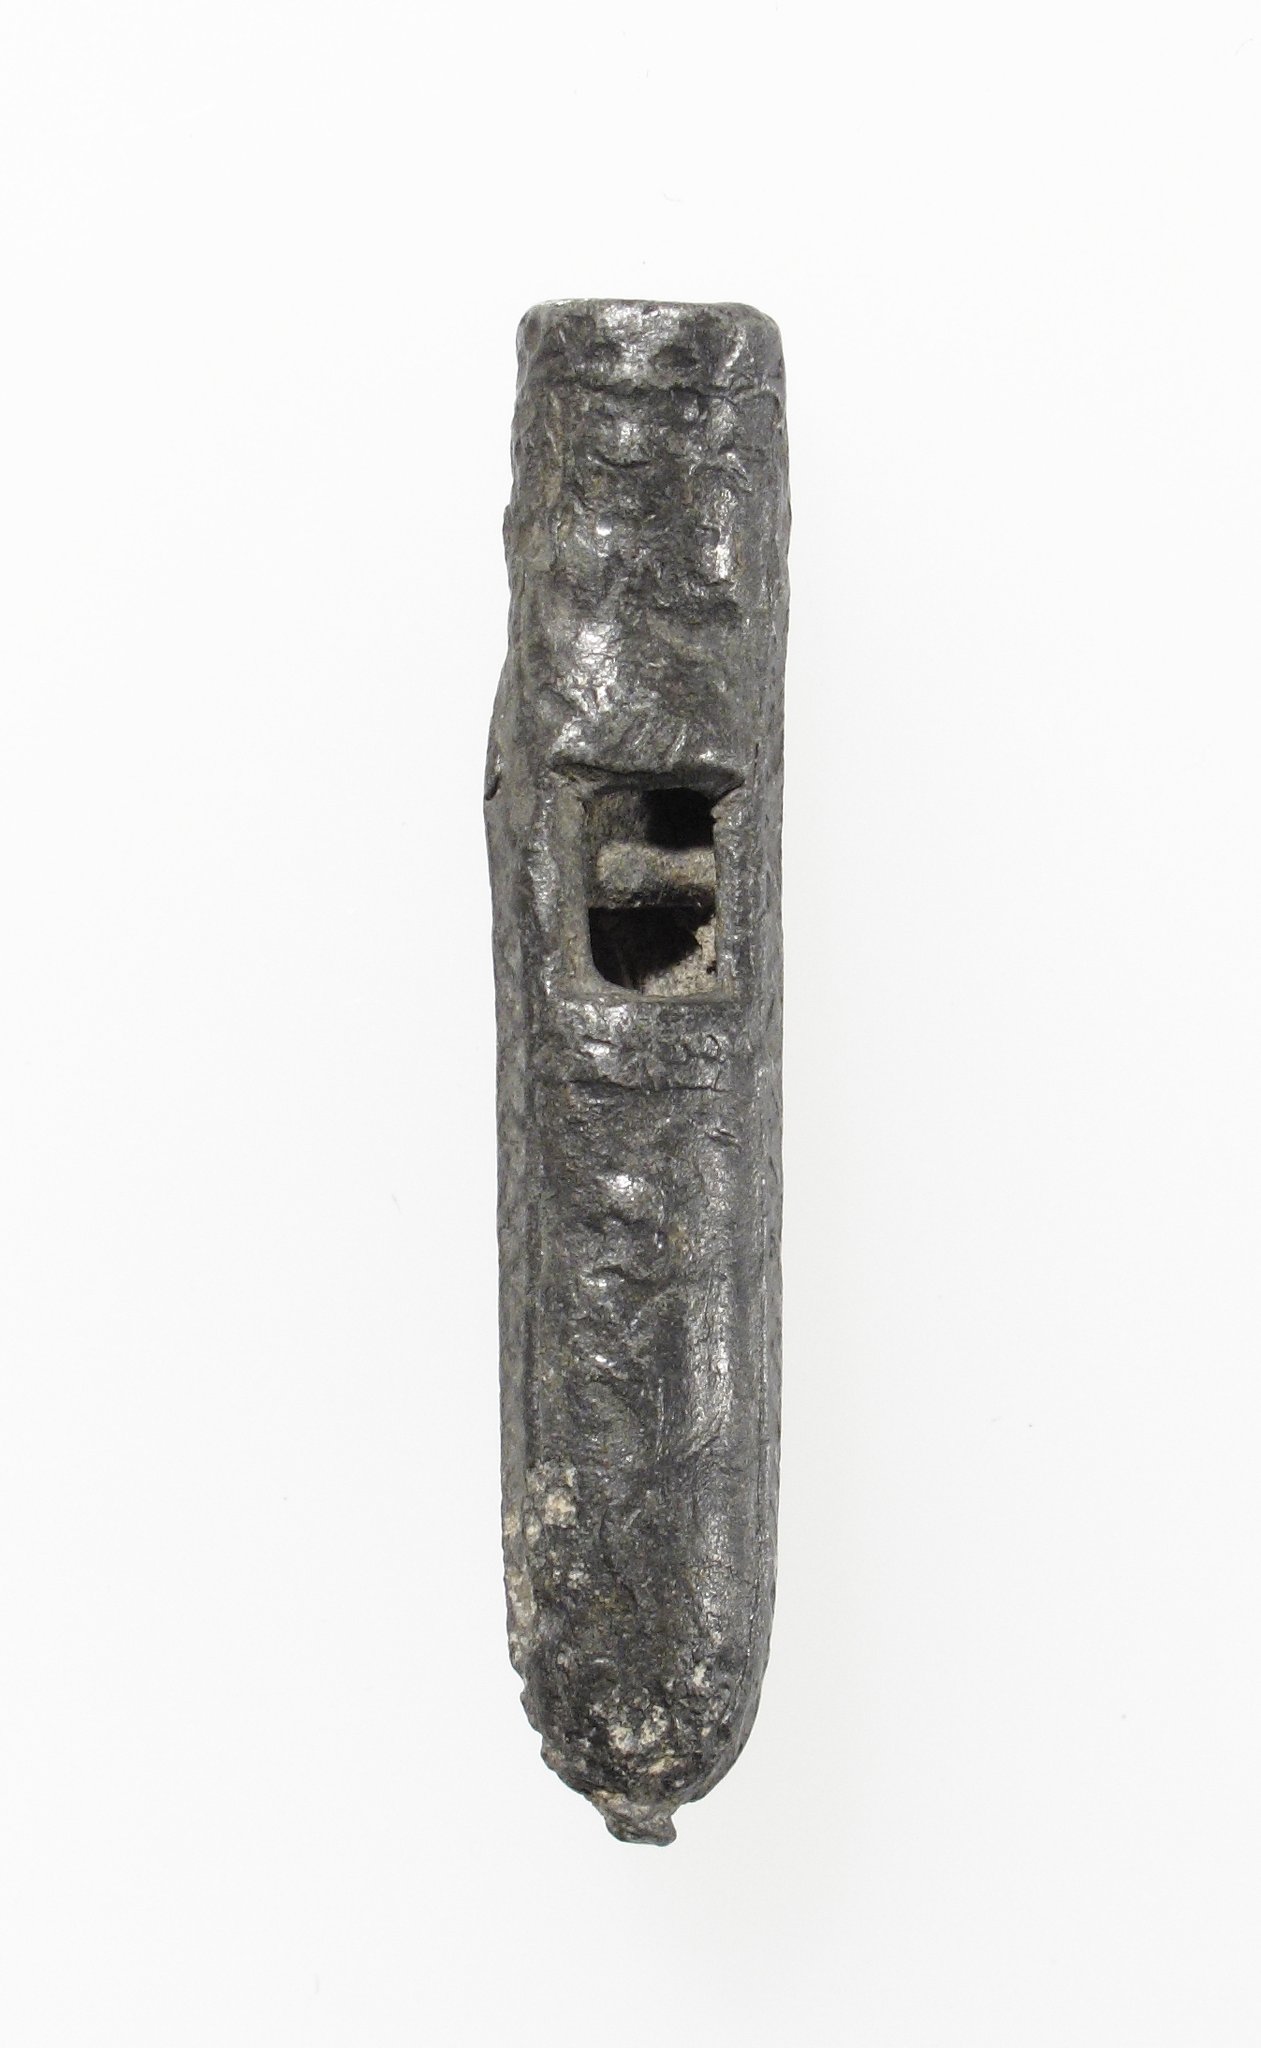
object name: pilgrim's badge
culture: french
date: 1301-1600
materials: lead